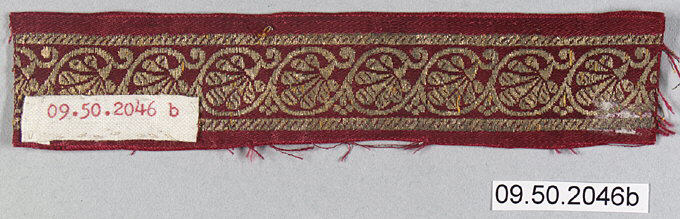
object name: textile fragment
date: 1801-1900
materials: metal thread, silk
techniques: brocade, satin weave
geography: india